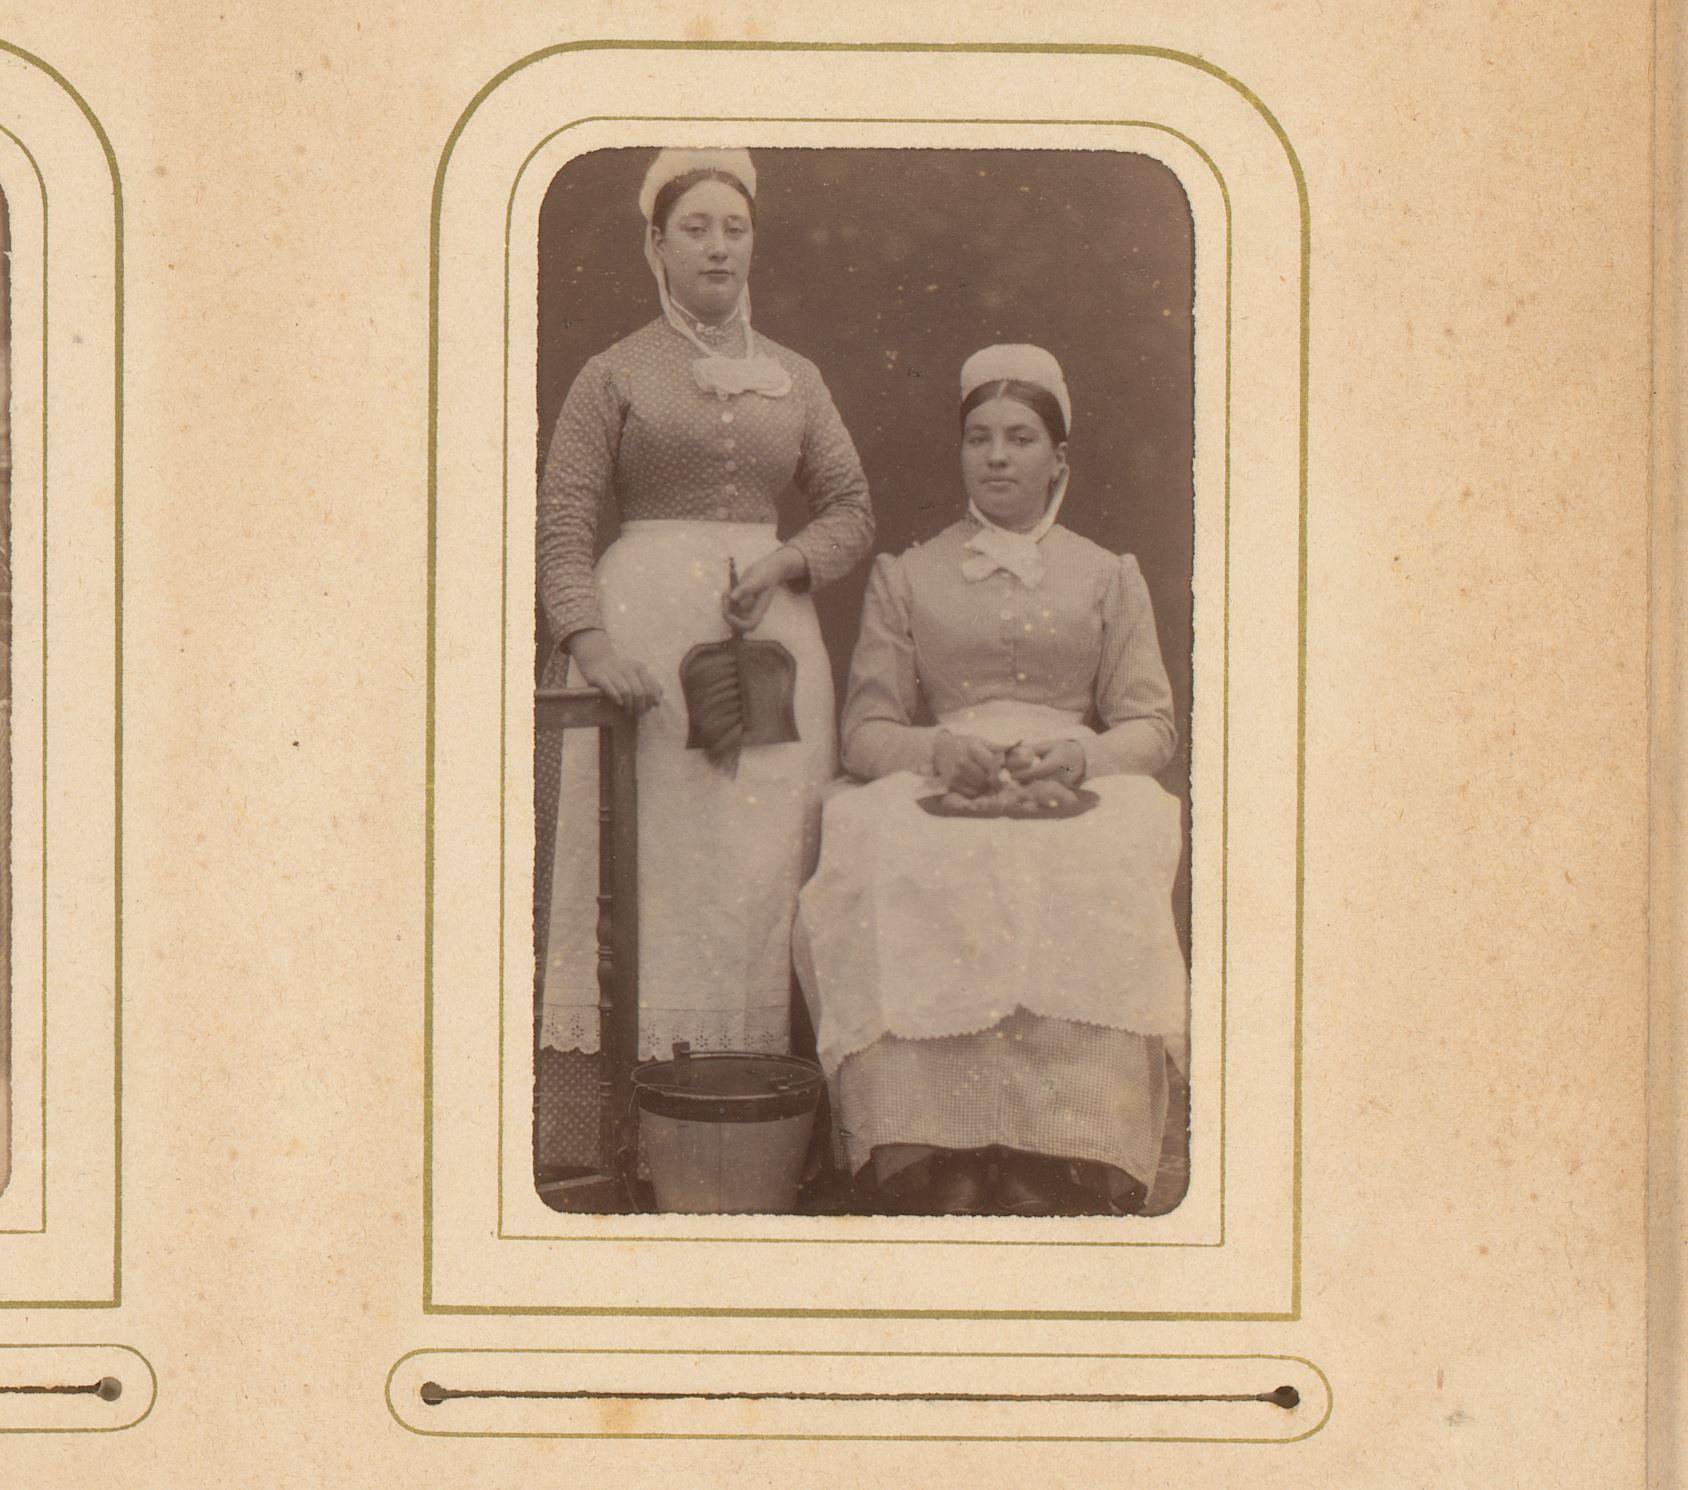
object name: photograph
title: Carte-de-visite Portraits of Domestic Workers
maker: johannes adrianus klümpes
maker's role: fotograaf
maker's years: 1843-1899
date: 1889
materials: cardboard, photographic support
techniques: albumen print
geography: rotterdam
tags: historical persons - bb - woman, adult woman (+ two persons), maid ~ house personnel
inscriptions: inscription: ‘J. A. Klümpes/ Rotterdam/ Hang 71/ deze plaat blyft bewaard.’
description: The woman in the upper left photograph is Lina Hamming, a domestic worker in Amsterdam. Hamming was one of thousands of women who worked in the households of wealthy families. We do not know the names of the other women, but we do know their occupation: domestic workers. They wore the characteristic white aprons and caps. The baskets and the dustpan and brush indicate their duties in the household.